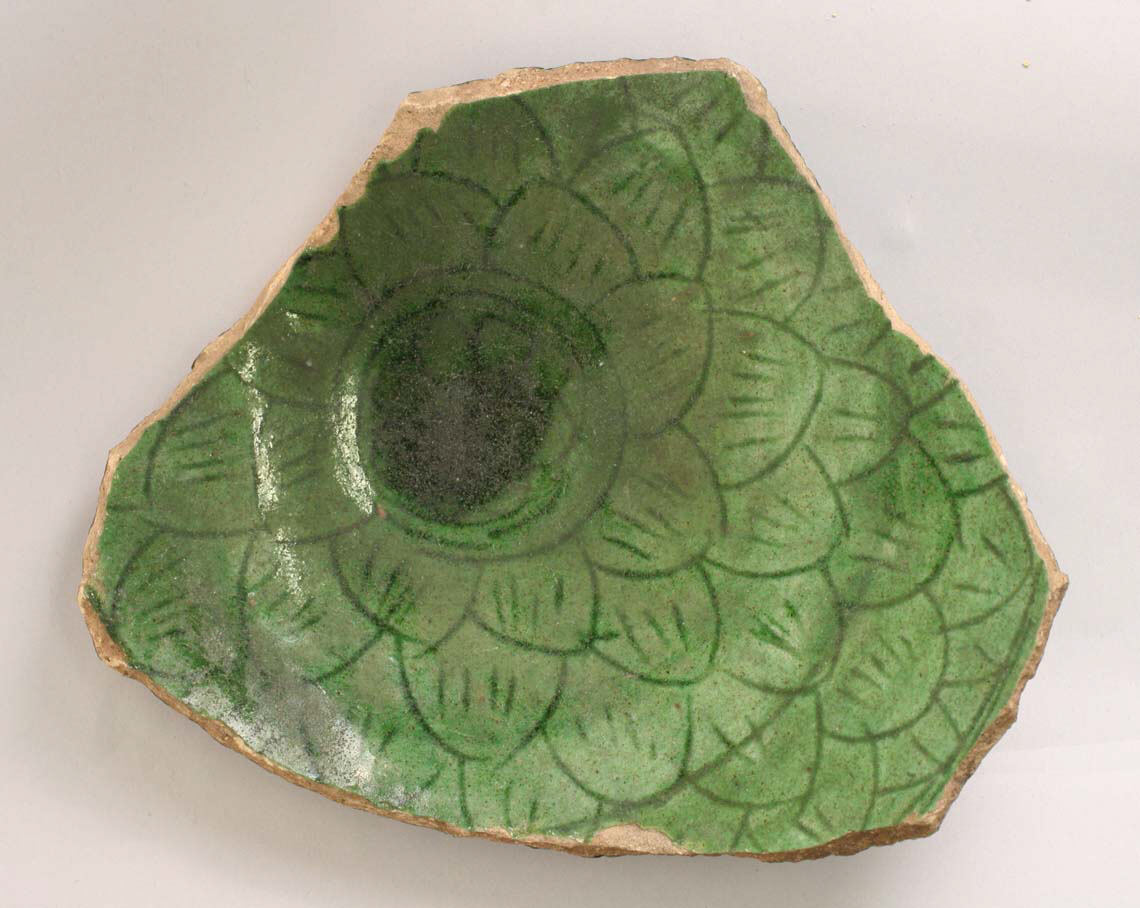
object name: ceramic fragment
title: Fragment of a Bowl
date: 1201-1400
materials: earthenware, glaze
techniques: incising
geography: egypt